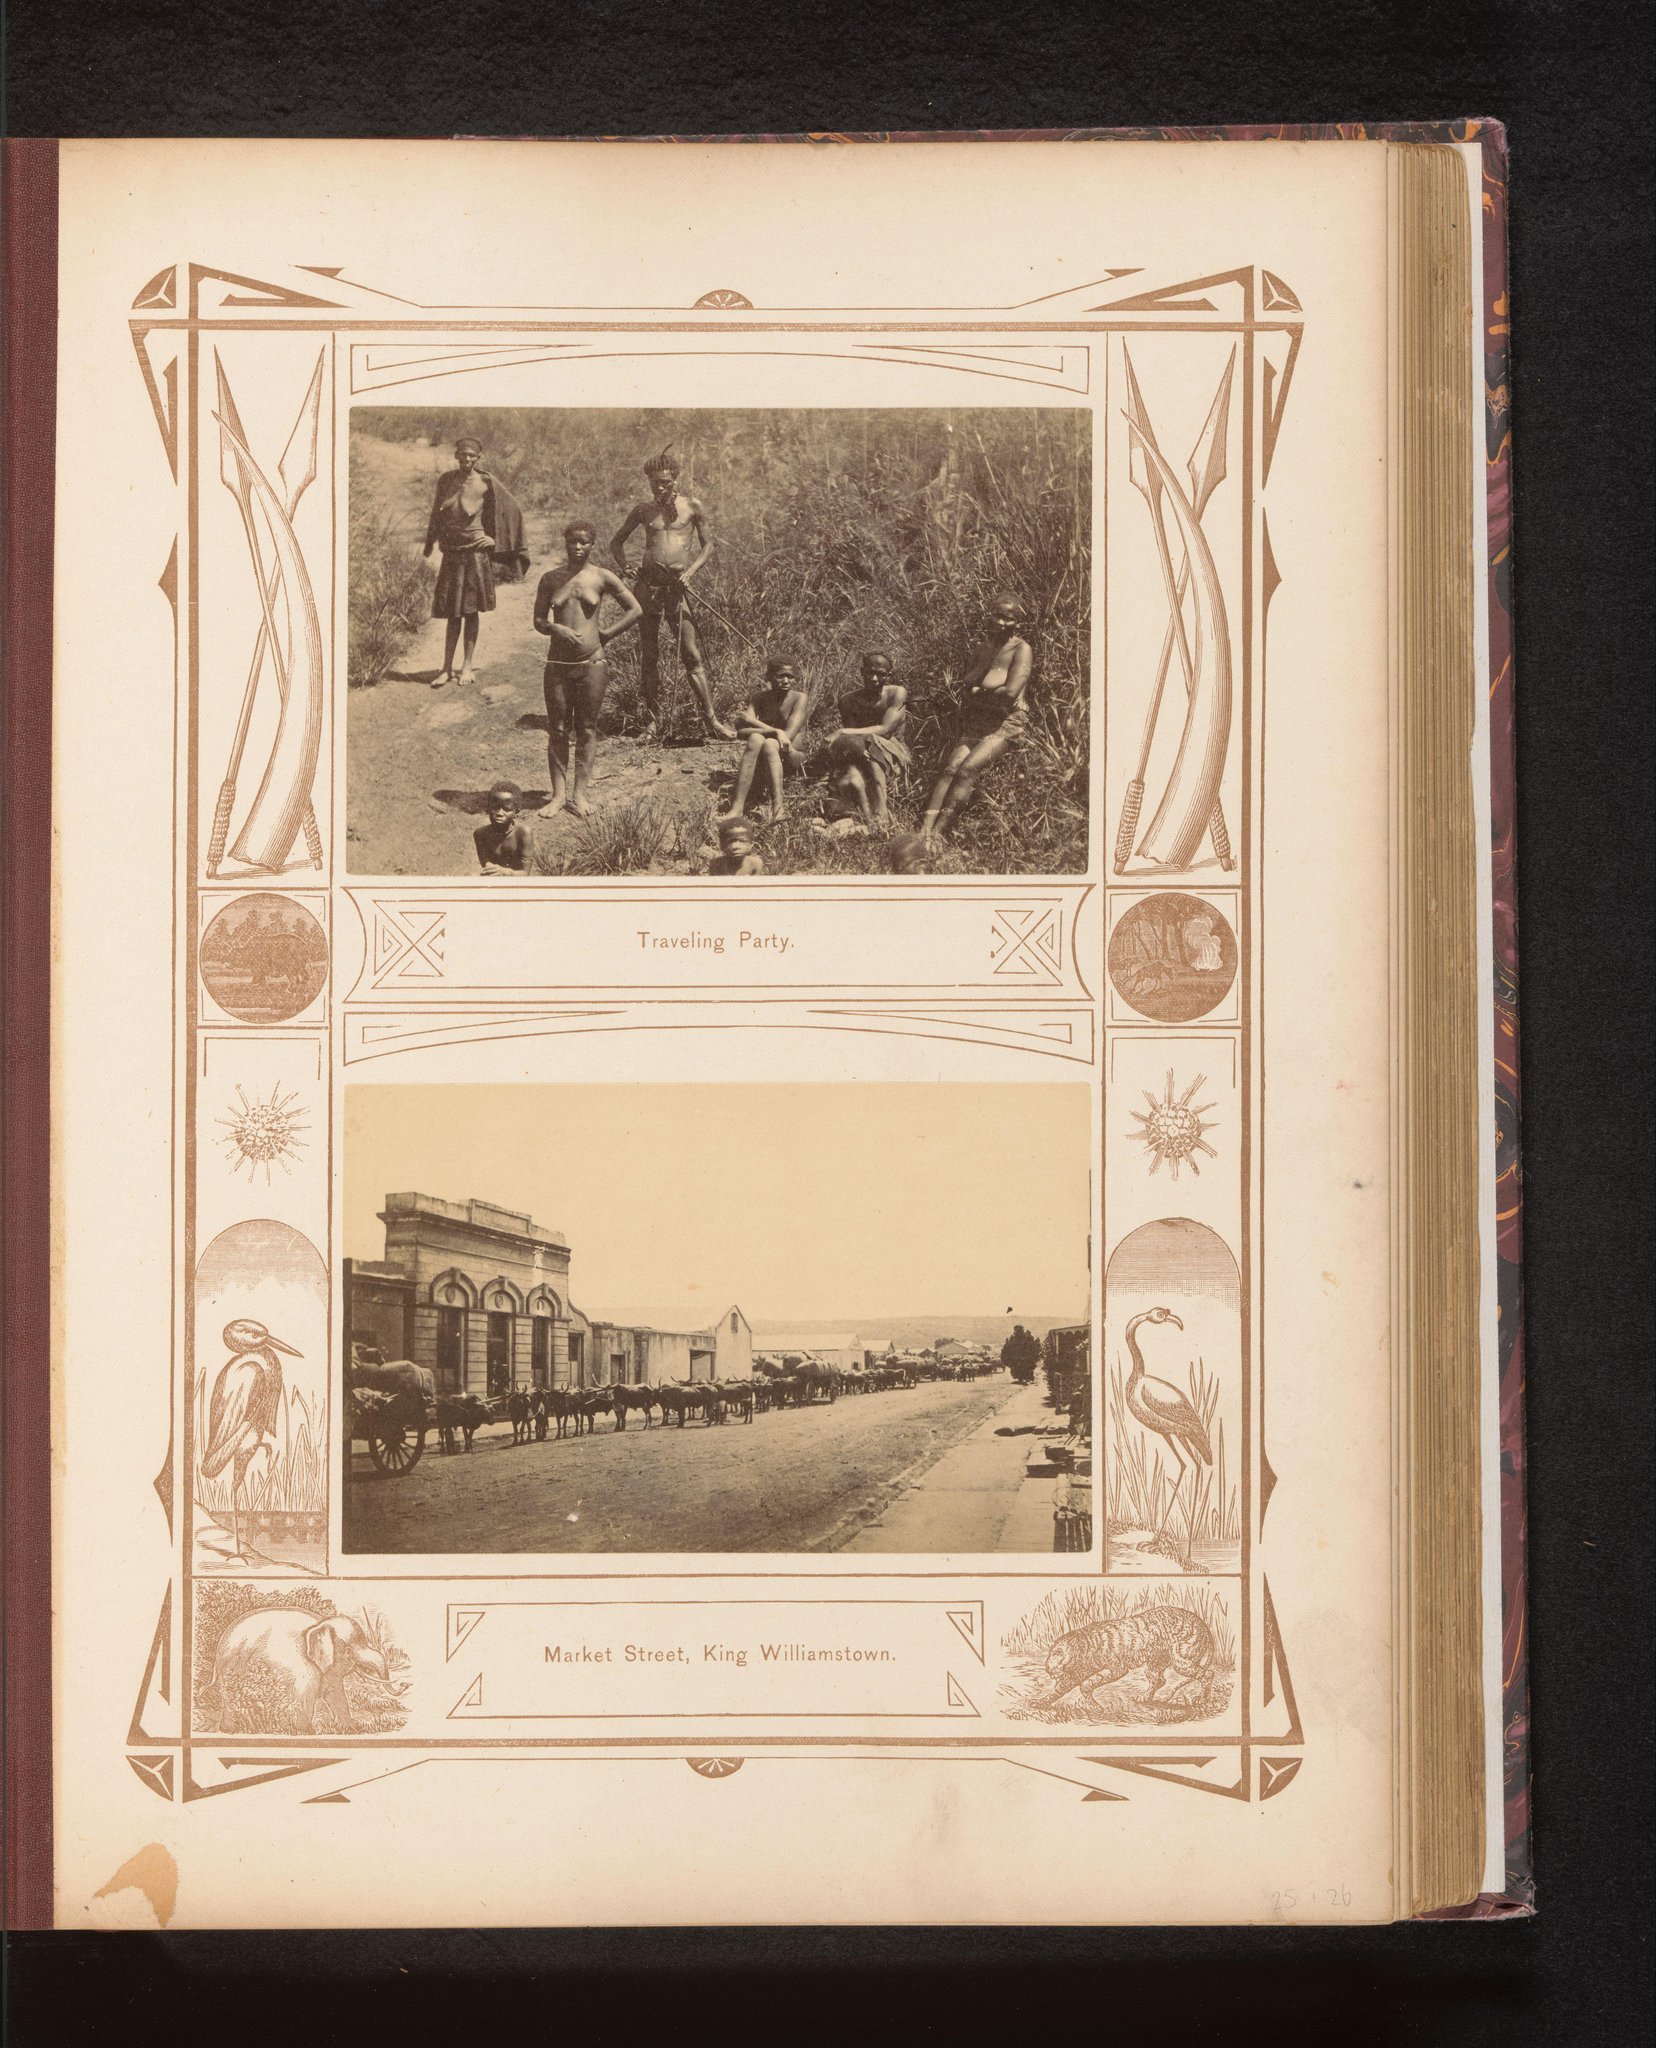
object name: photograph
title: Een groep onbekende Afrikaanse personen in een landschap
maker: Anonymous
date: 1877-1882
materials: photographic support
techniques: albumen print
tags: landscapes, anonymous historical persons portrayed in a group, in a group-portrait